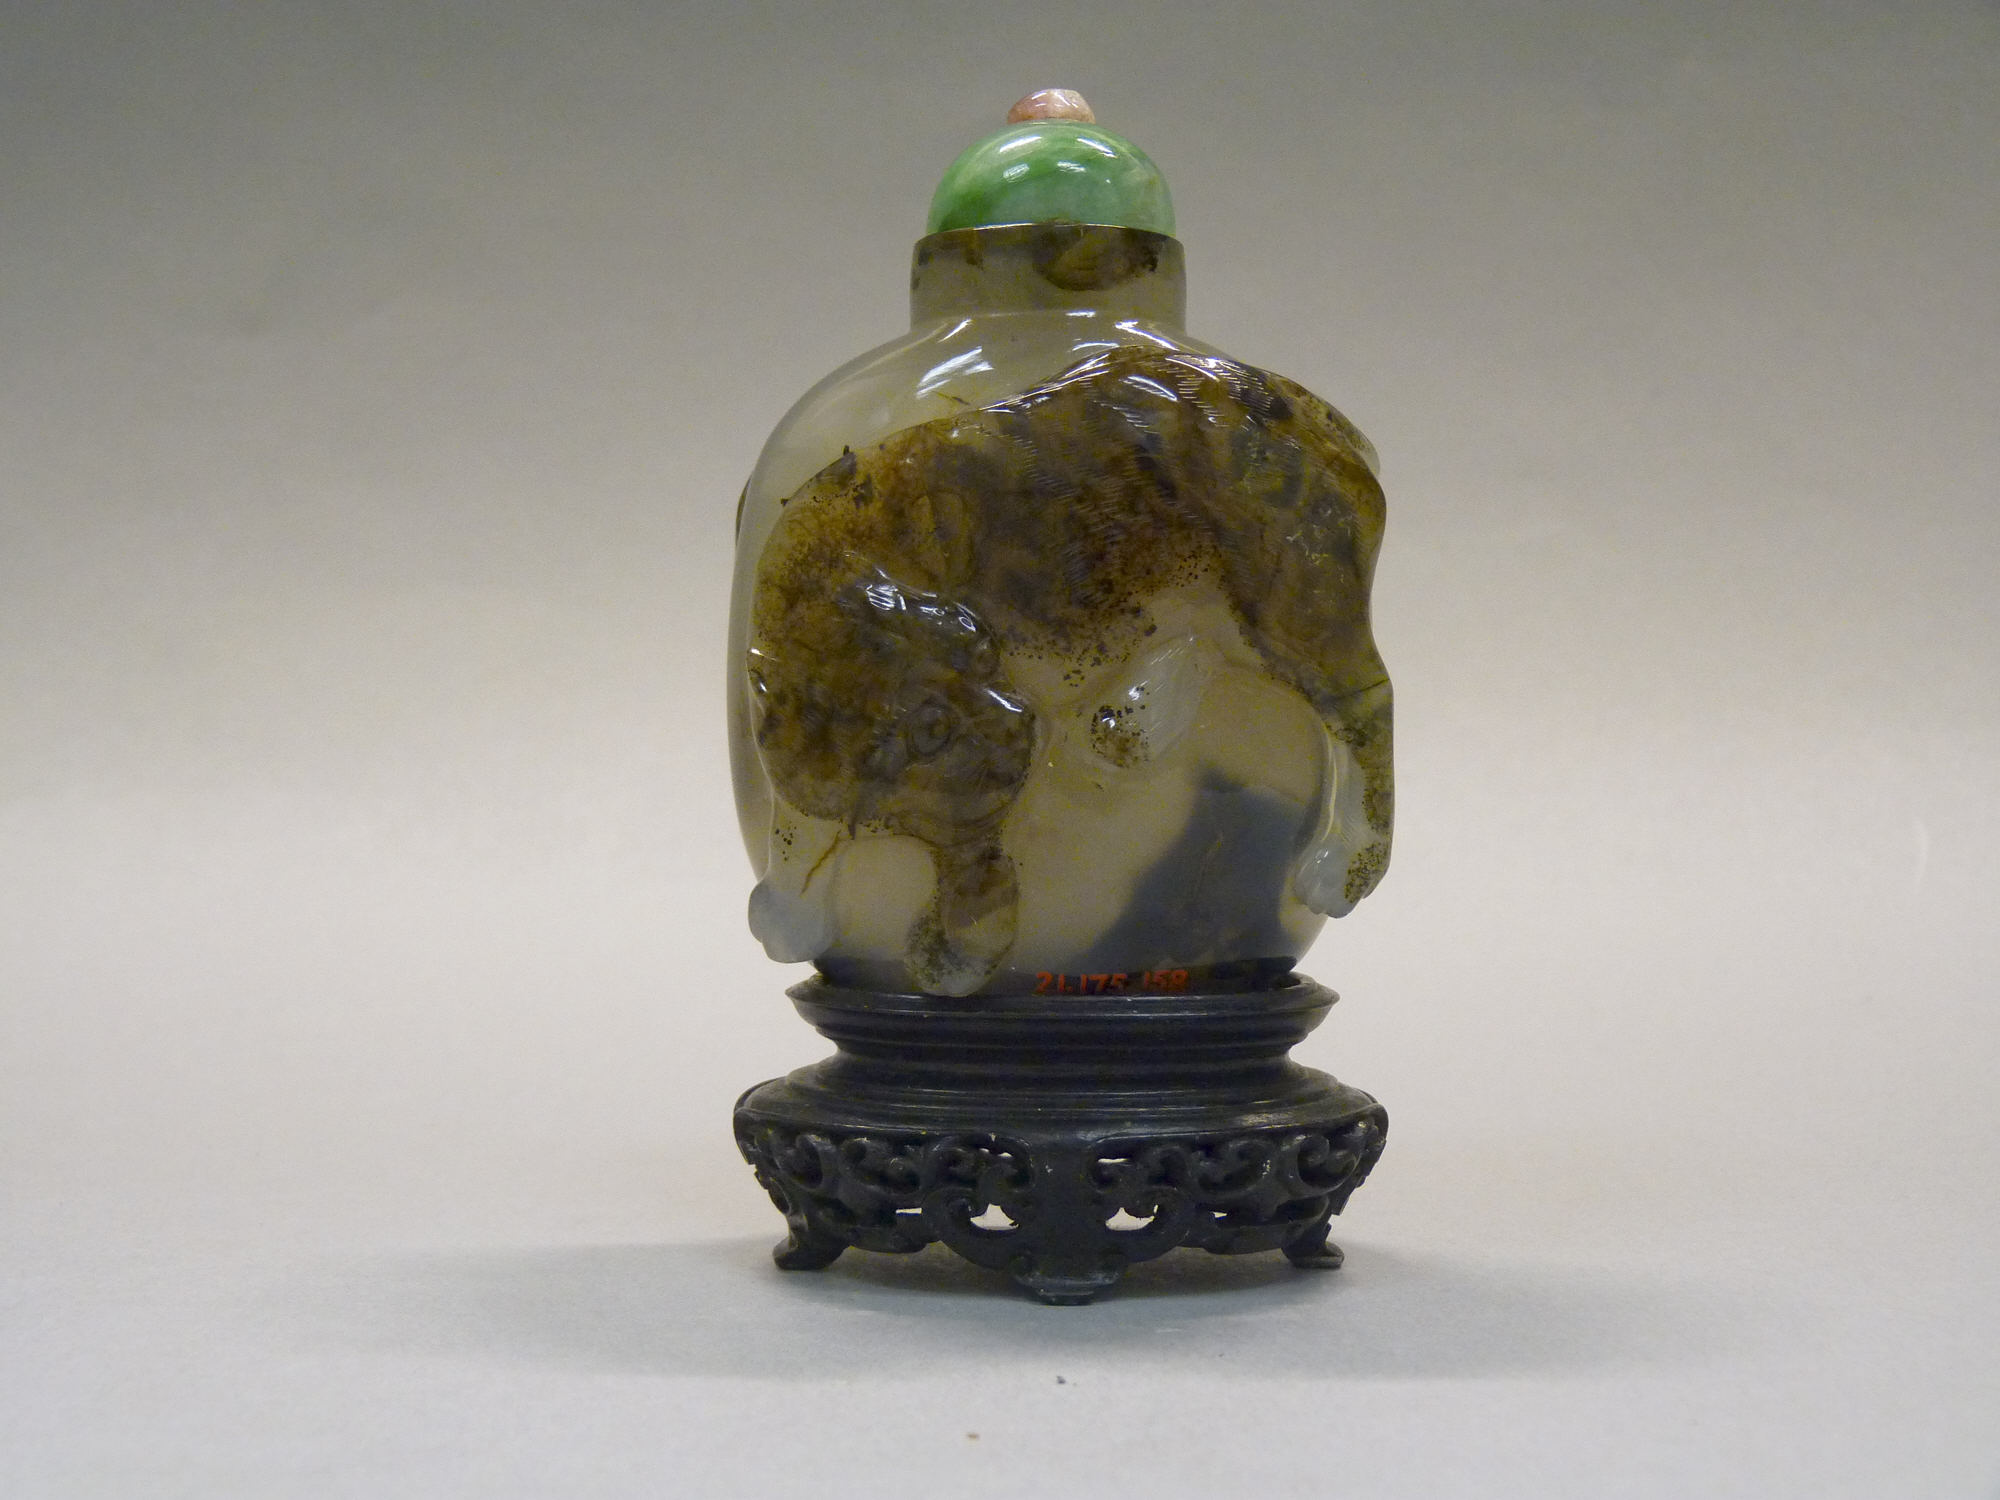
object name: snuff bottle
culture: chinese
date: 1736-1795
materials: stone, jade, gemstone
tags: animals